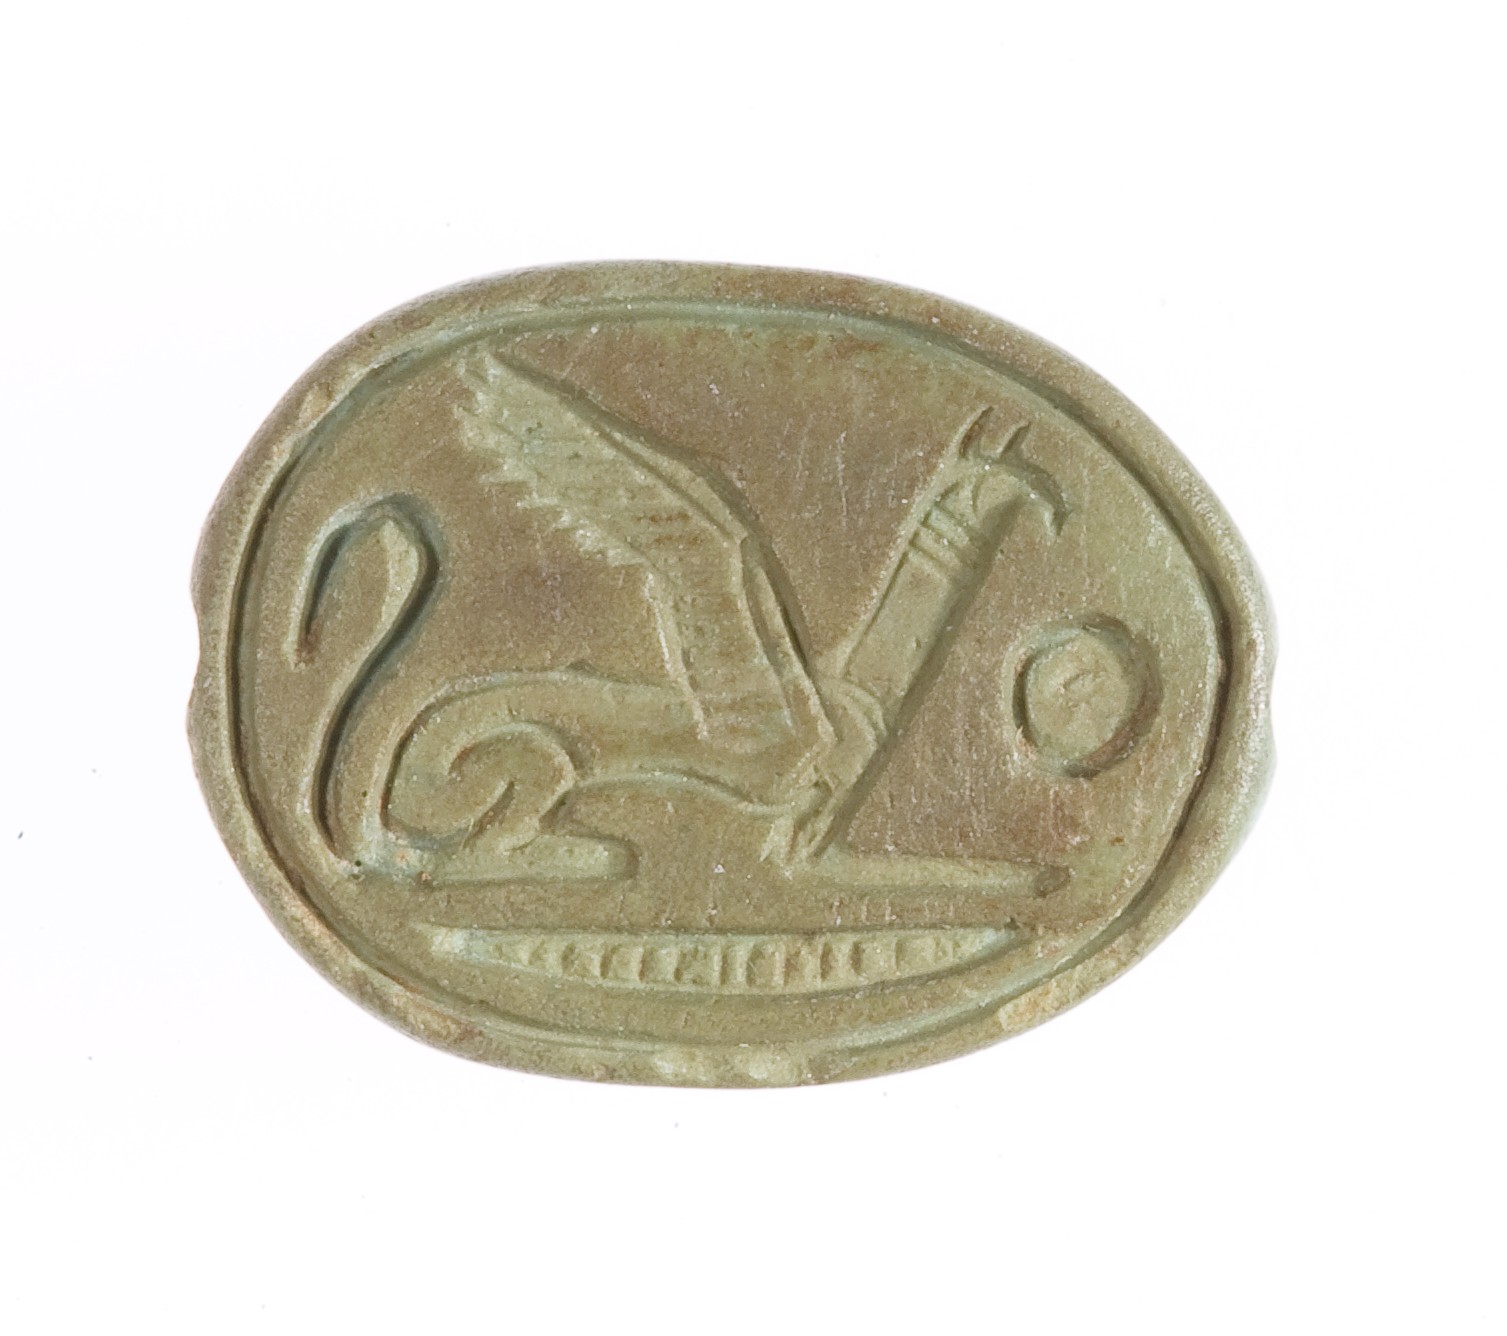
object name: scarab, griffin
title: Scarab with seated griffin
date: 1635-1458 BCE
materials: stone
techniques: glazing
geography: egypt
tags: griffins